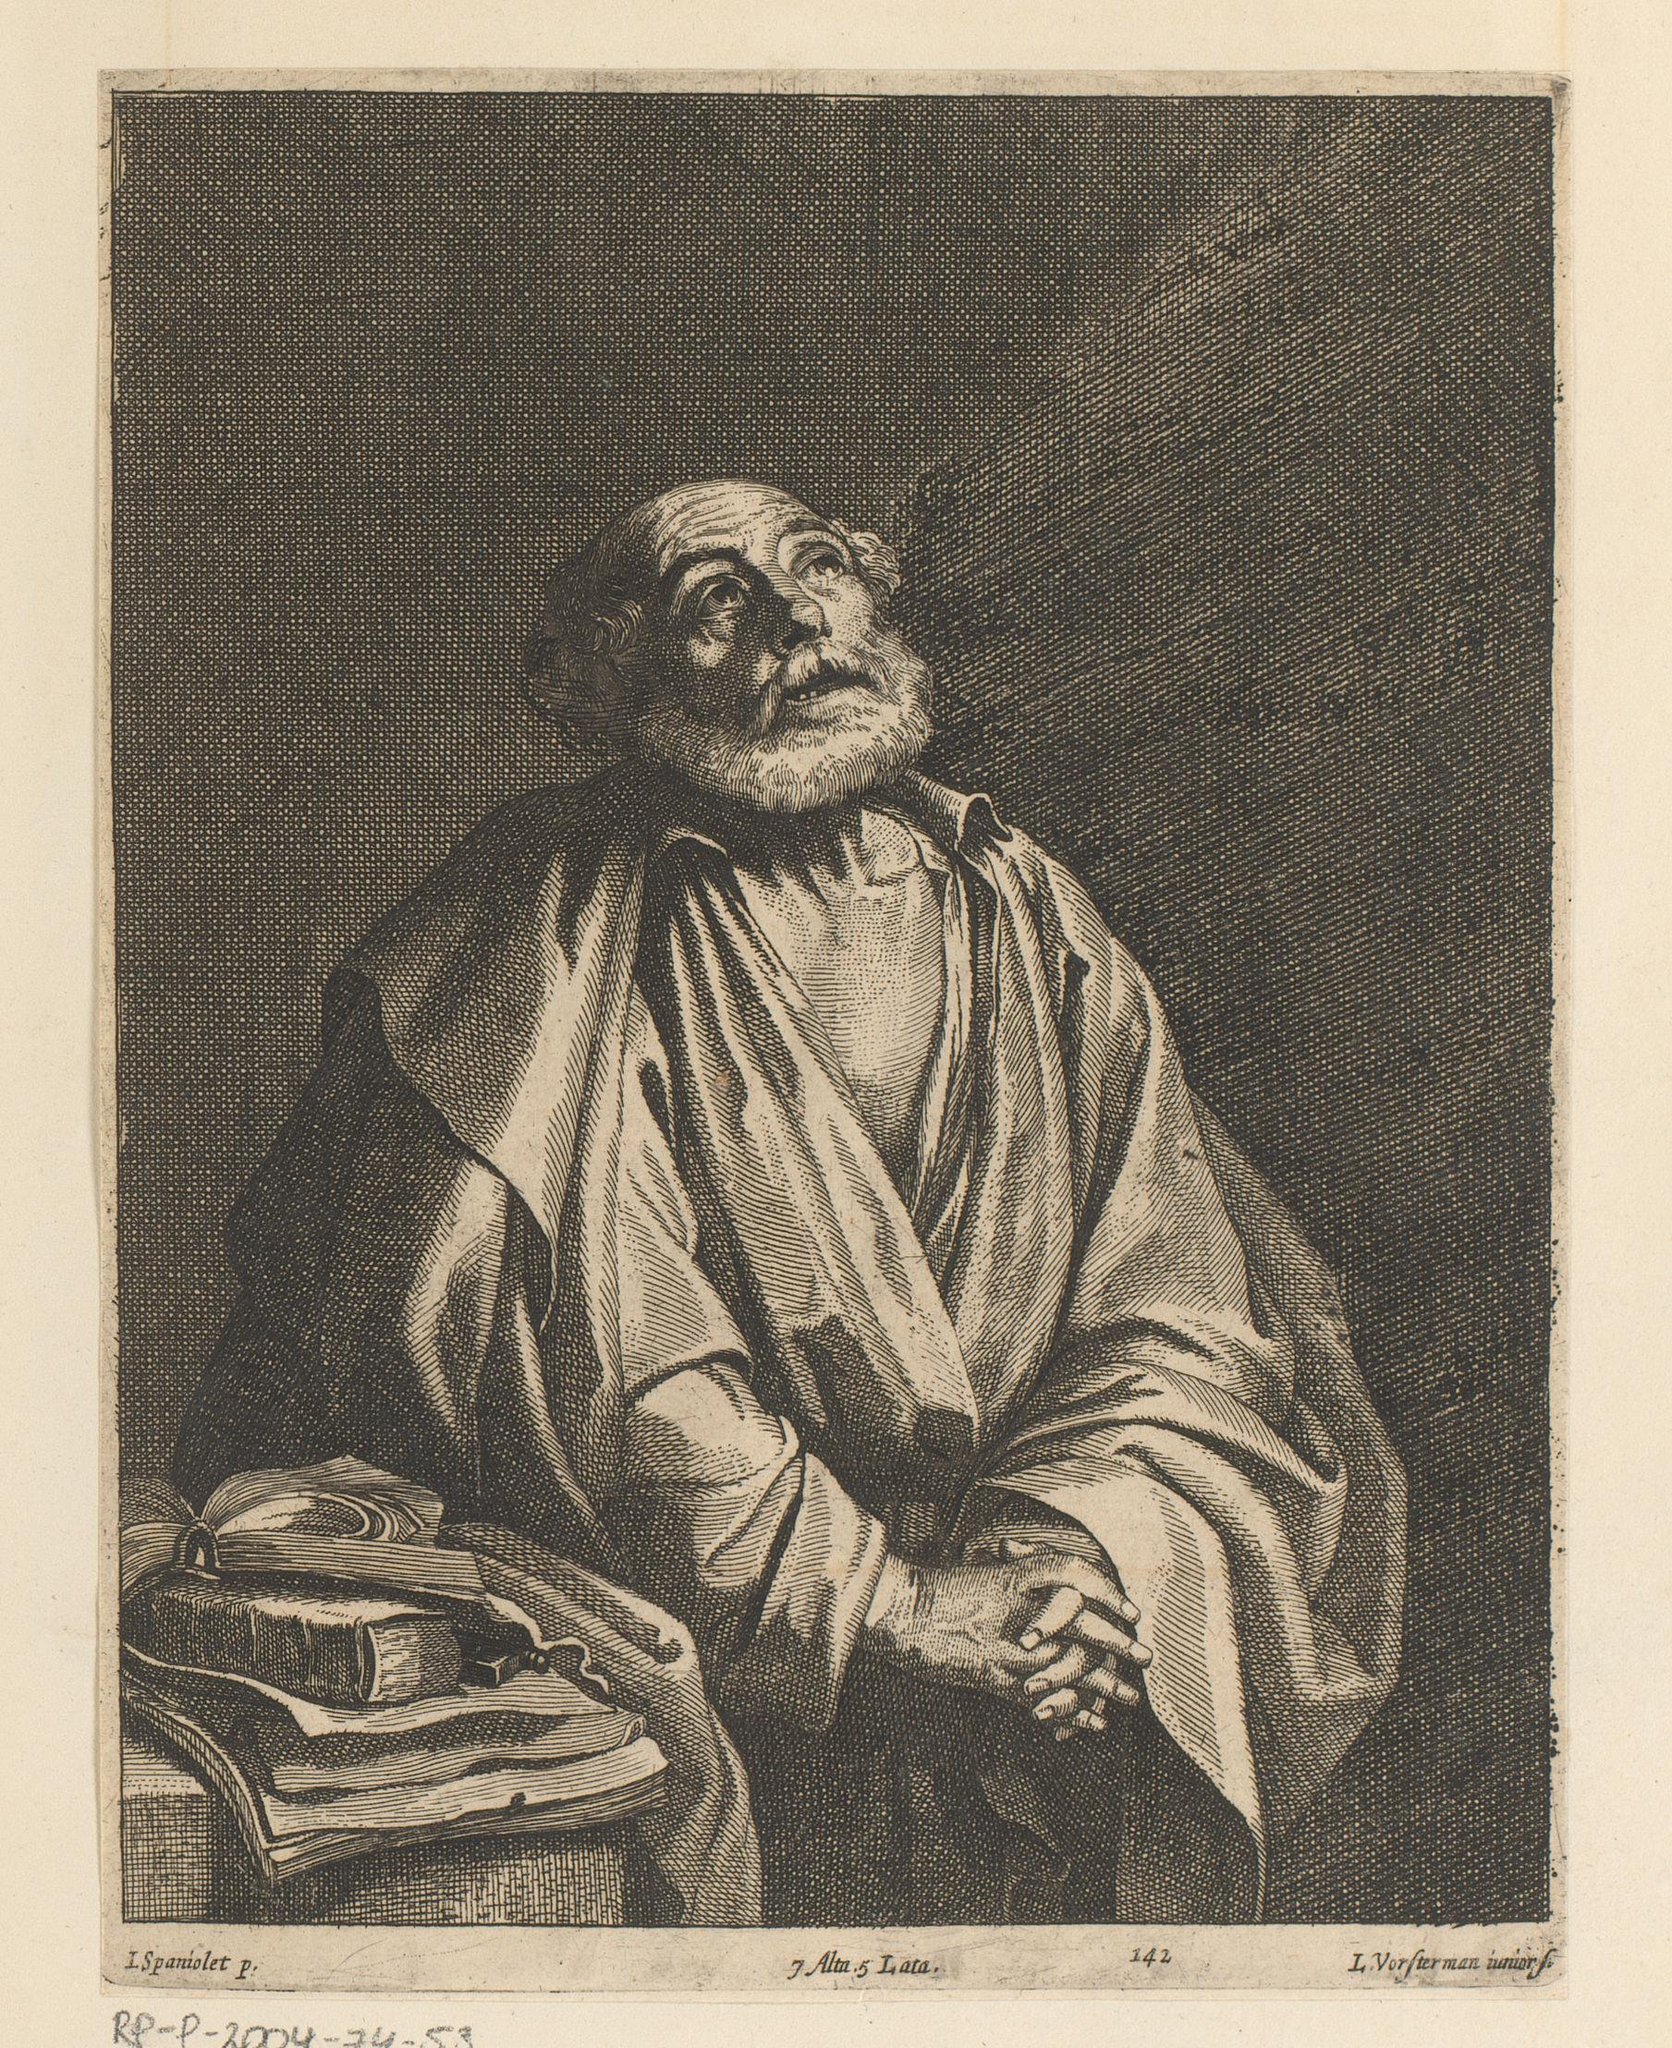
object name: album leaf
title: Berouw van Petrus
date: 1660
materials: paper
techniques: engraving, etching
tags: repentance of peter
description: Prent mogelijk gebruikt in de serie 'Schilder-Toneel' door David Teniers uitgegeven in 1660. De samensteller heeft deze prent in het album geplakt als illustratie bij: Pilkington, Matthew en Johann Heinrich Füssli. A dictionary of painters, from the revival of the art to the present period. 4 dln. Londen: John Crowder, 1805, dl. 3, p. 410.